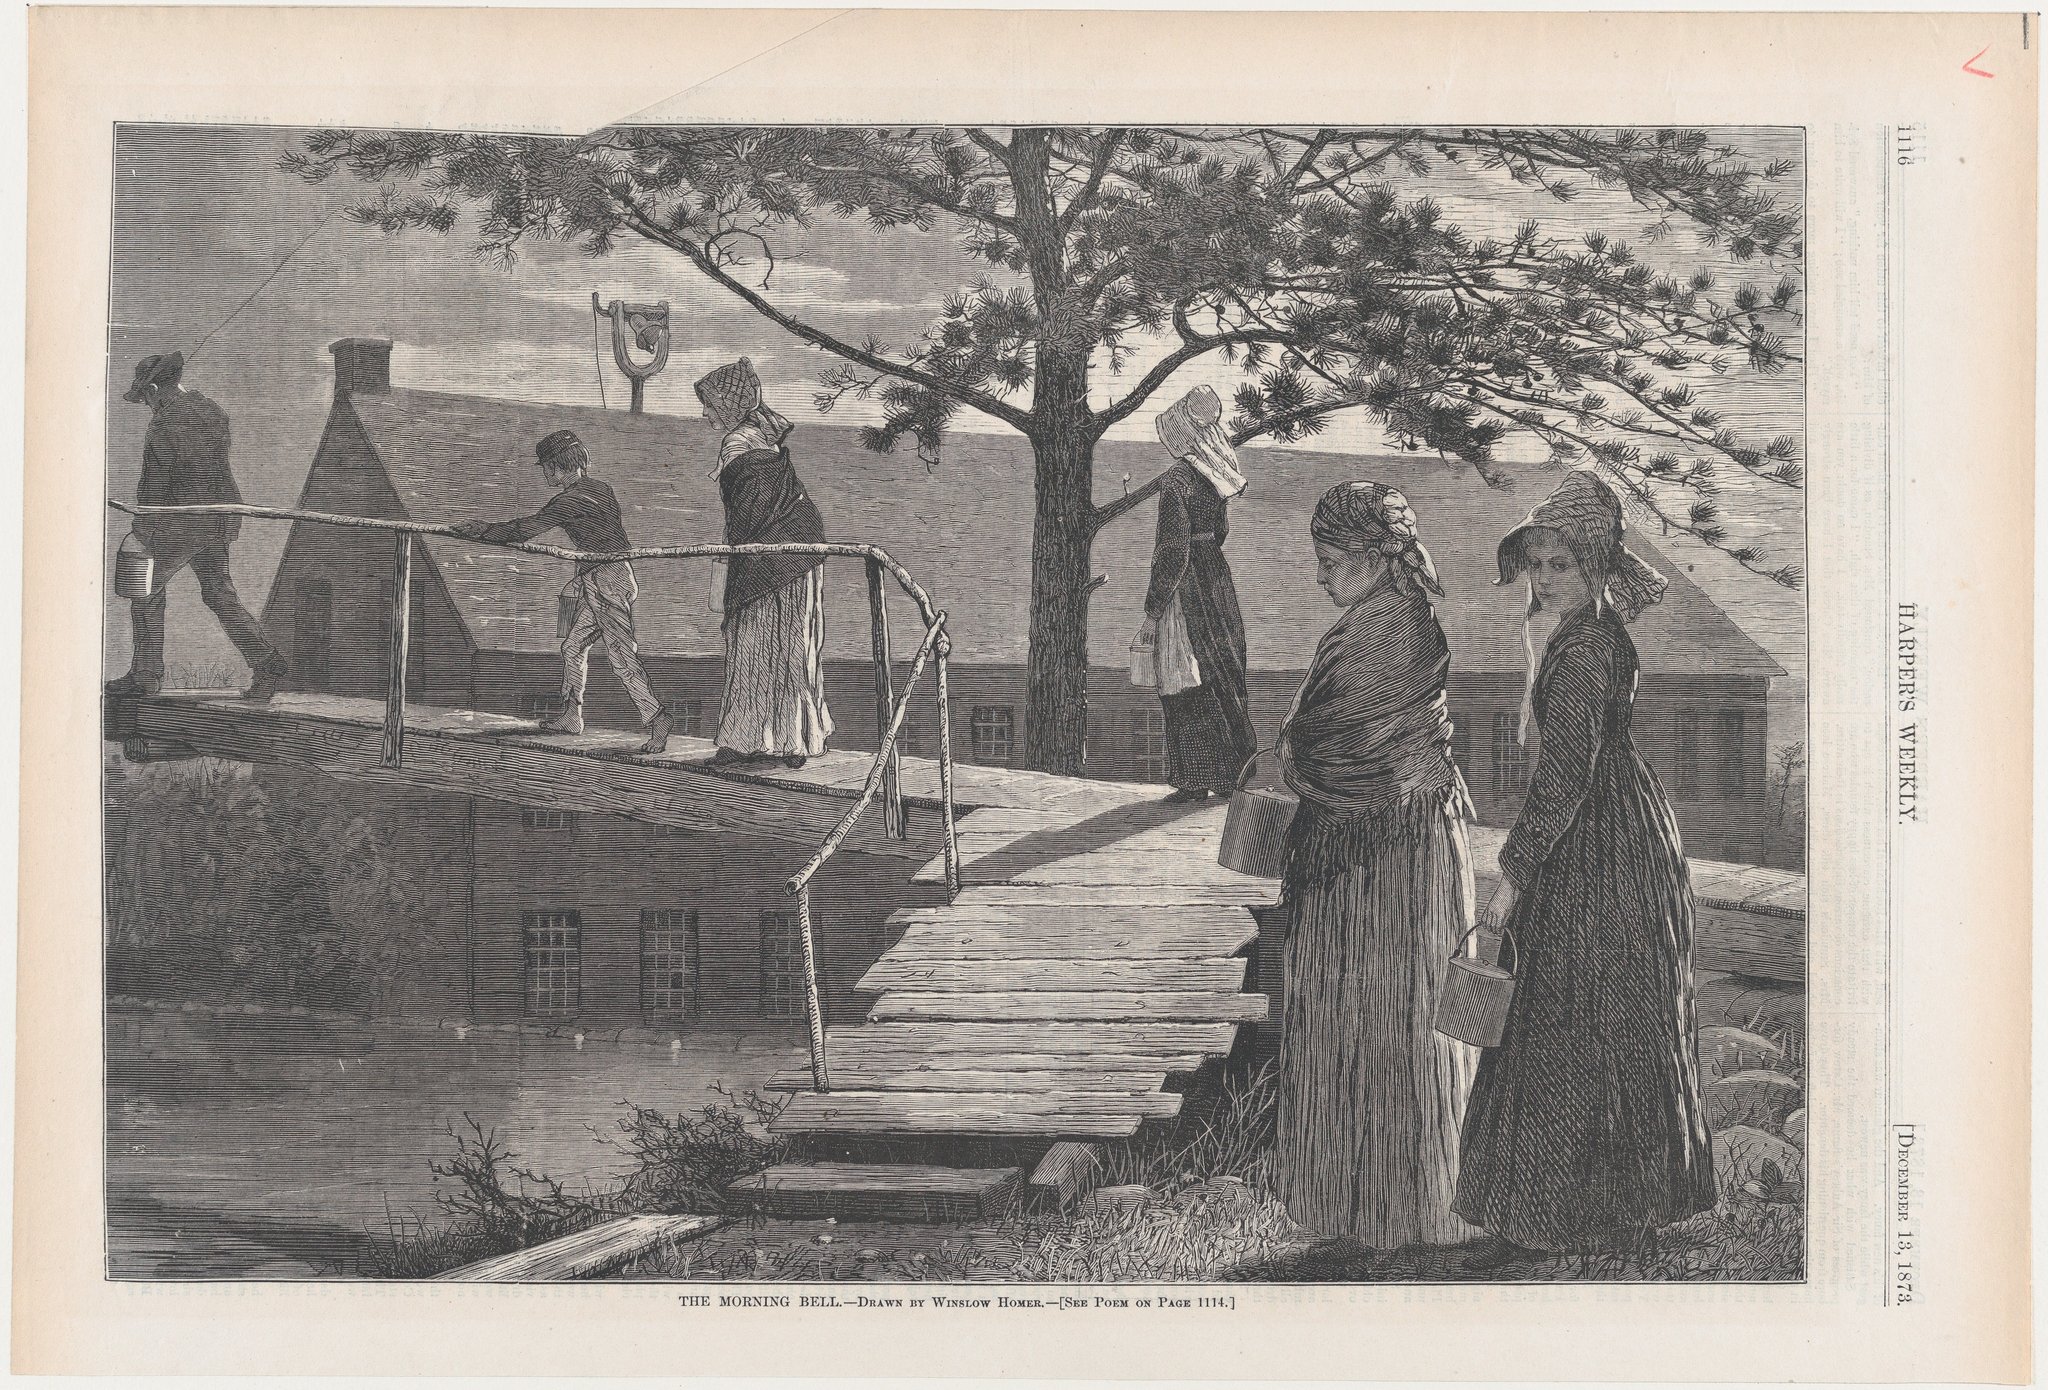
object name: print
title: The Morning Bell (from "Harper's Weekly," Vol. XVII)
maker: winslow homer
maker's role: artist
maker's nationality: american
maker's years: 1836-1910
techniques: engraving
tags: boys,men,women,walking,trees